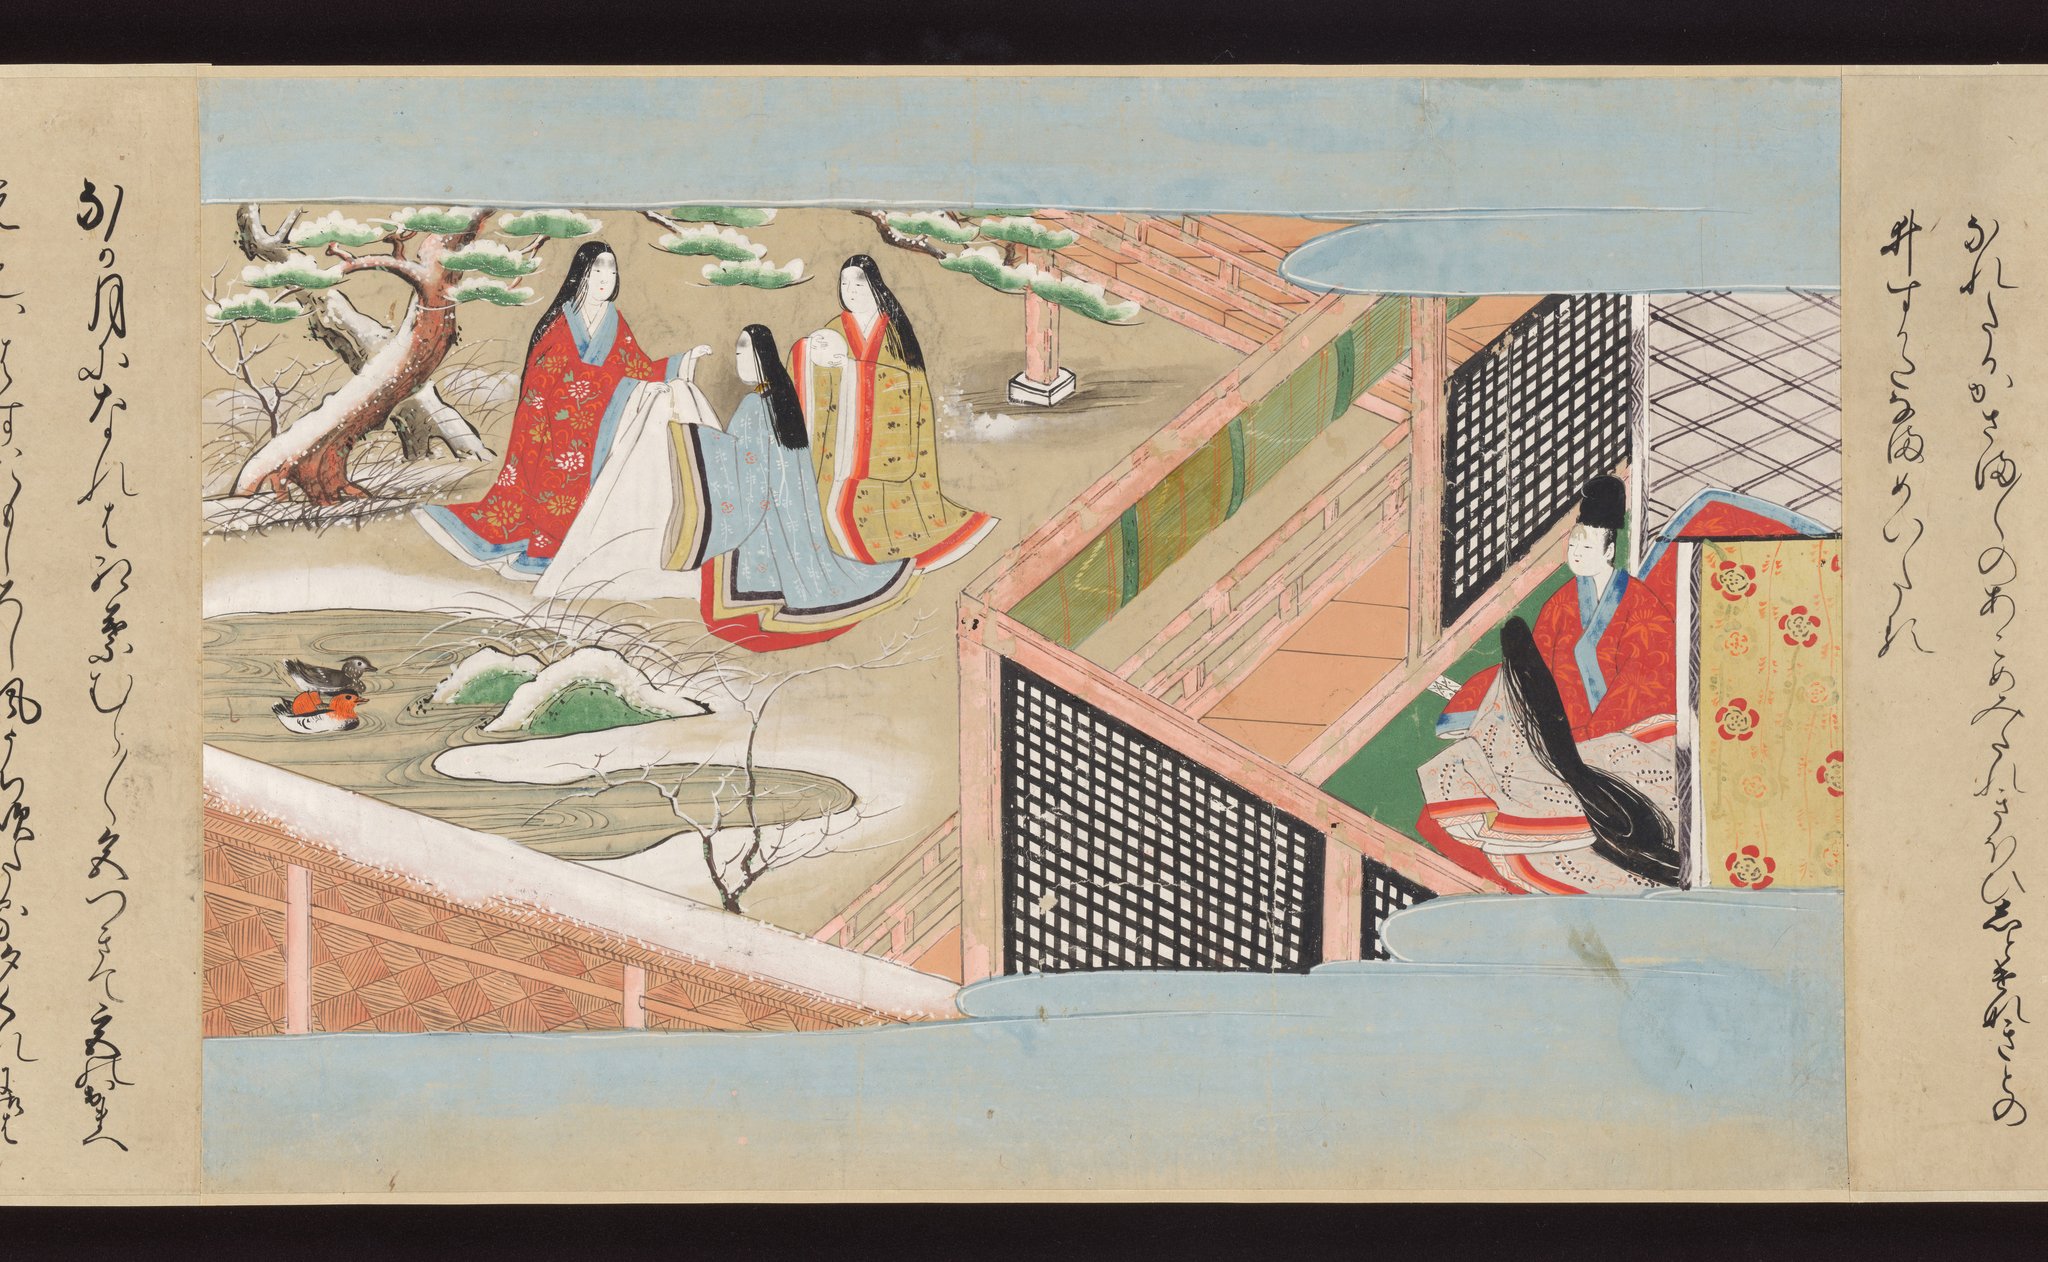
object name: handscroll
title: Illustrated Handscrolls of The Tale of Genji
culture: japanese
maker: ryūjo (tatsujo)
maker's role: artist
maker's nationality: japanese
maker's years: 1567-1599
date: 1594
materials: ink, paper